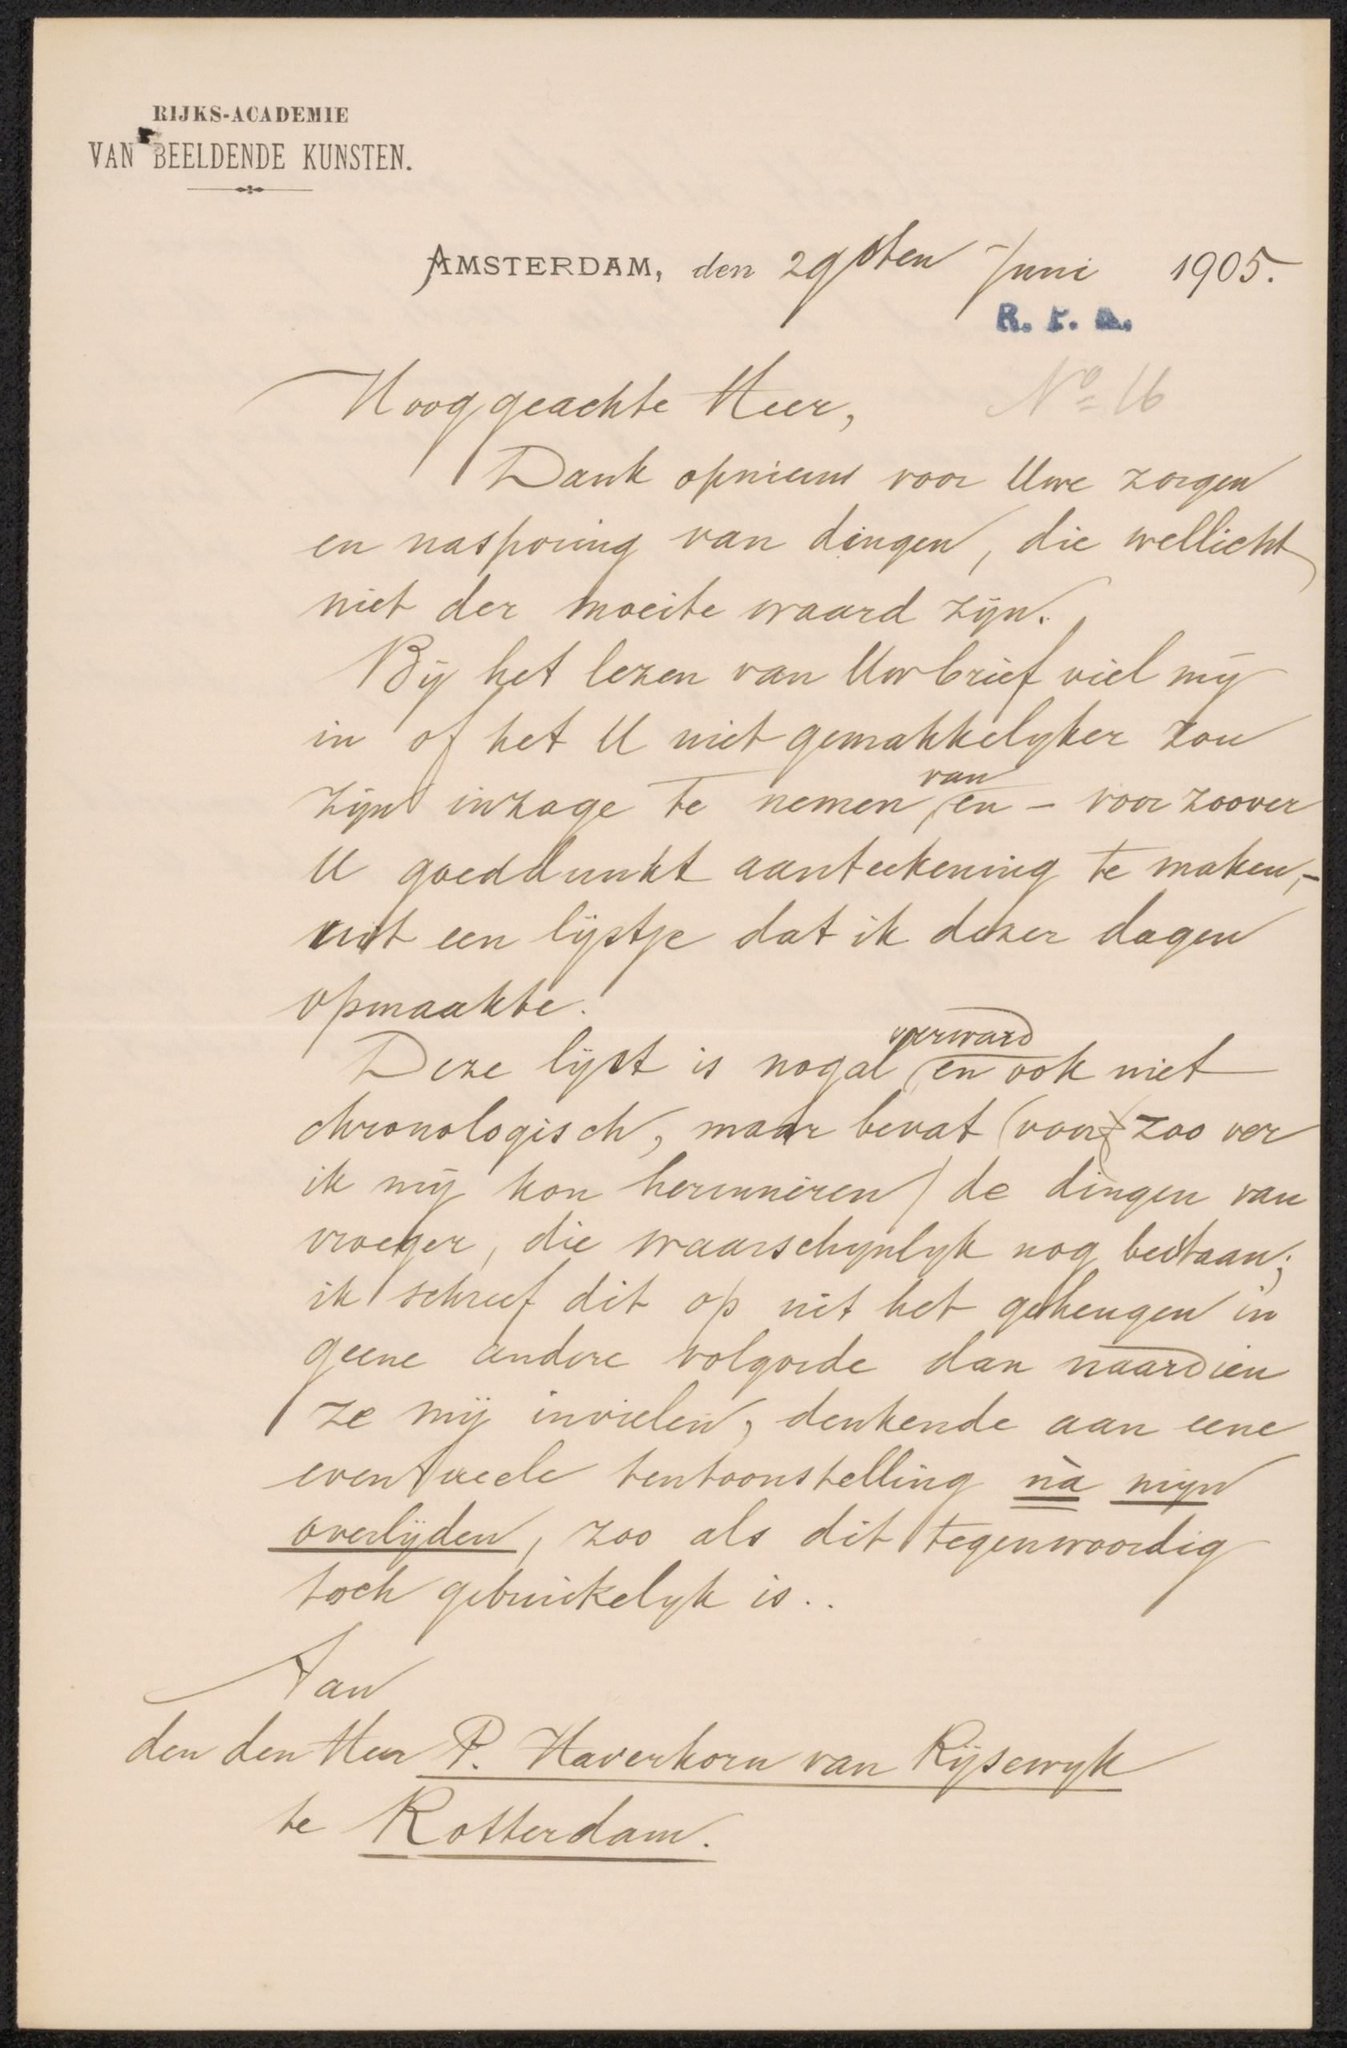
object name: letter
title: Brief aan Pieter Haverkorn van Rijsewijk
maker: august allebé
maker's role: draughtsman, print maker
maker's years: 1838-1927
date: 1905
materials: ink, paper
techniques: pen, printing, writing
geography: amsterdam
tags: brussels, painter, alfred stevens, jozef israëls, petrus franciscus greive, multatuli, pieter haverkorn van rijsewijk, marienbad, the graphic arts, exhibition ~ art, historical persons (portraits and scenes from the life)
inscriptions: collector's mark: Lugt 2233